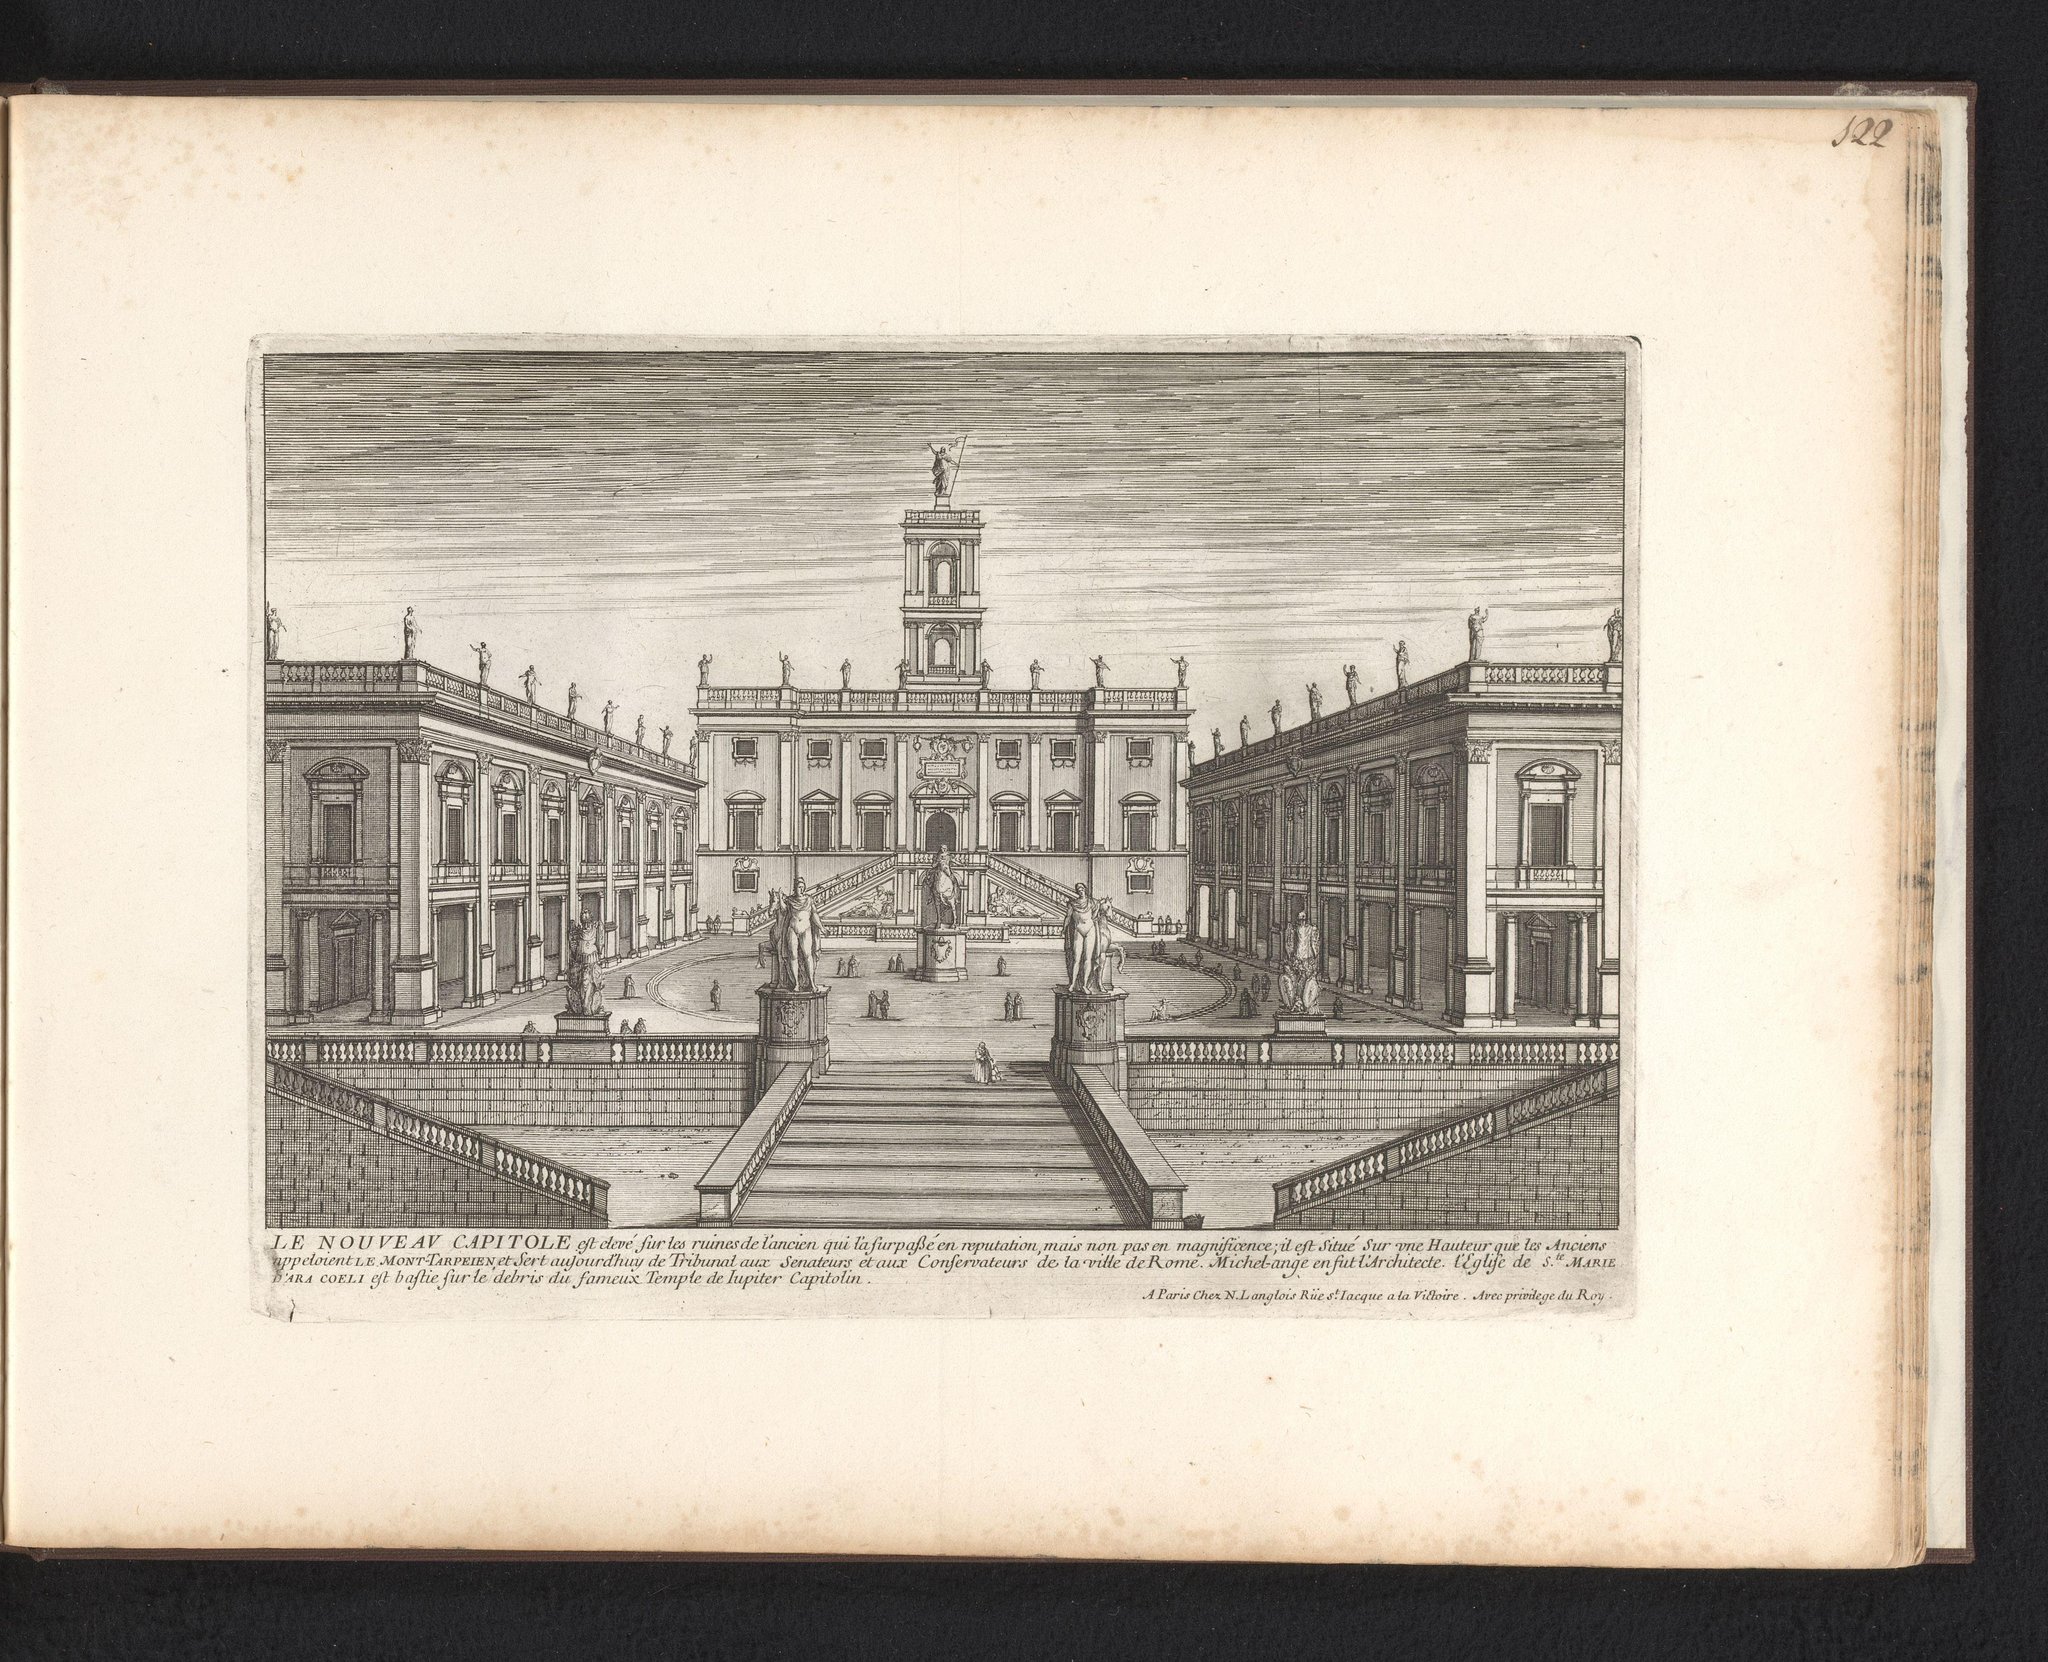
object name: print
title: Recueil de vues de monuments de Paris, des principales résidences royales et des principaux châteaux de France et de Rome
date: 1650-1695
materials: paper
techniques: etching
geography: paris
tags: city-view in general; 'veduta'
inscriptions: collector's mark: Lugt 2228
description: Prenten met het signatuur 'Perelle' kunnen zowel door vader Gabriel als door zonen Nicolas en Adam gemaakt zijn. De uitgevers vader en zoon Nicolas Langlois worden allebei vermeld als N. Langlois op hetzelfde adres.